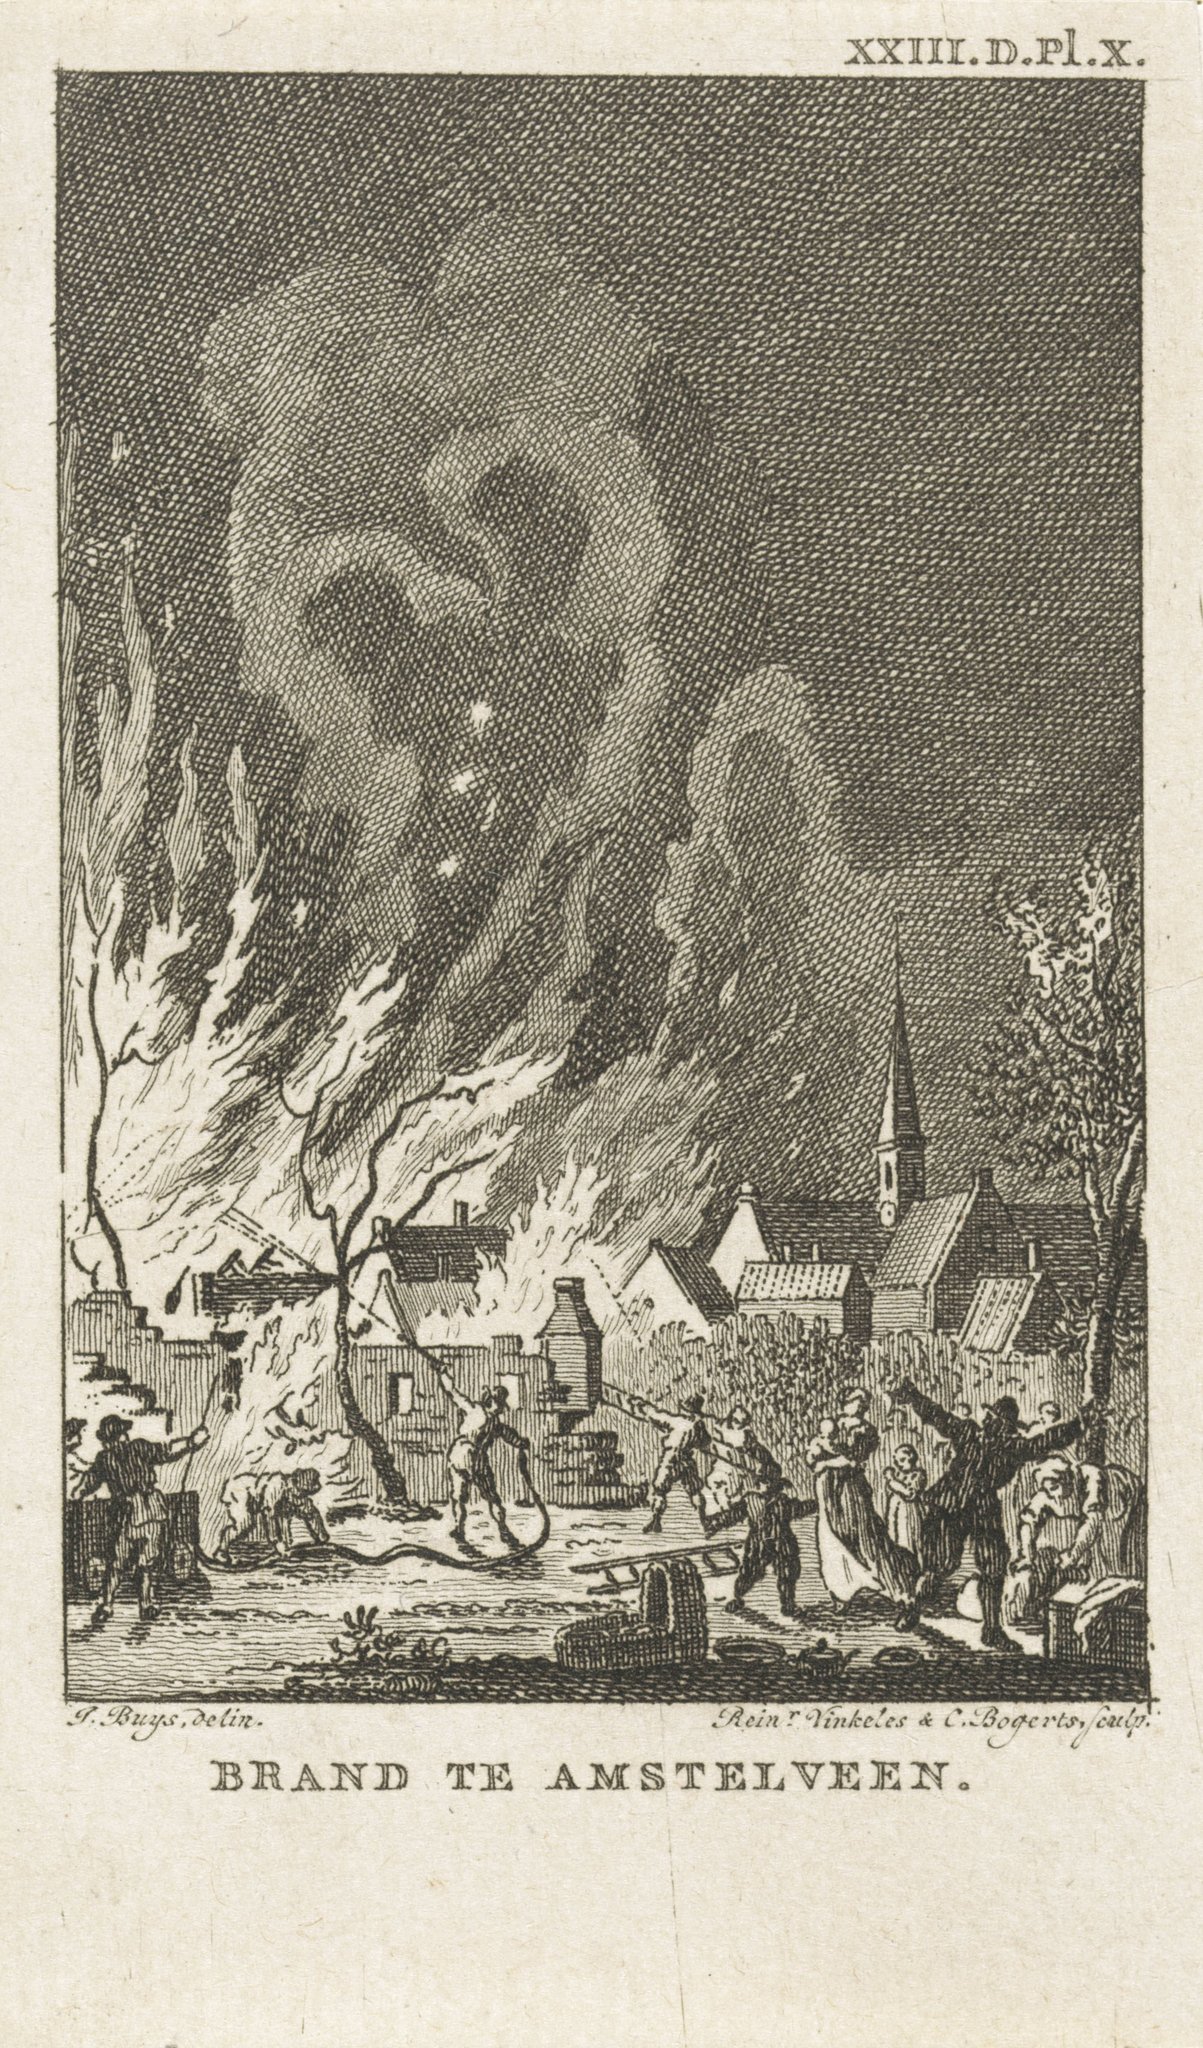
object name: print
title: Brand te Amstelveen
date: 1792-1795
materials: paper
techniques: etching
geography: northern netherlands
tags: on fire, ablaze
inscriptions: collector's mark: Lugt 2228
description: Gebruikt als illustratie in: J. Fokke, Geschiedenissen der Vereenigde Nederlanden voor de vaderlandsche jeugd, Johannes Allart, Amsterdam 1783-1795, 25 delen, dl. 23, pl. 10.